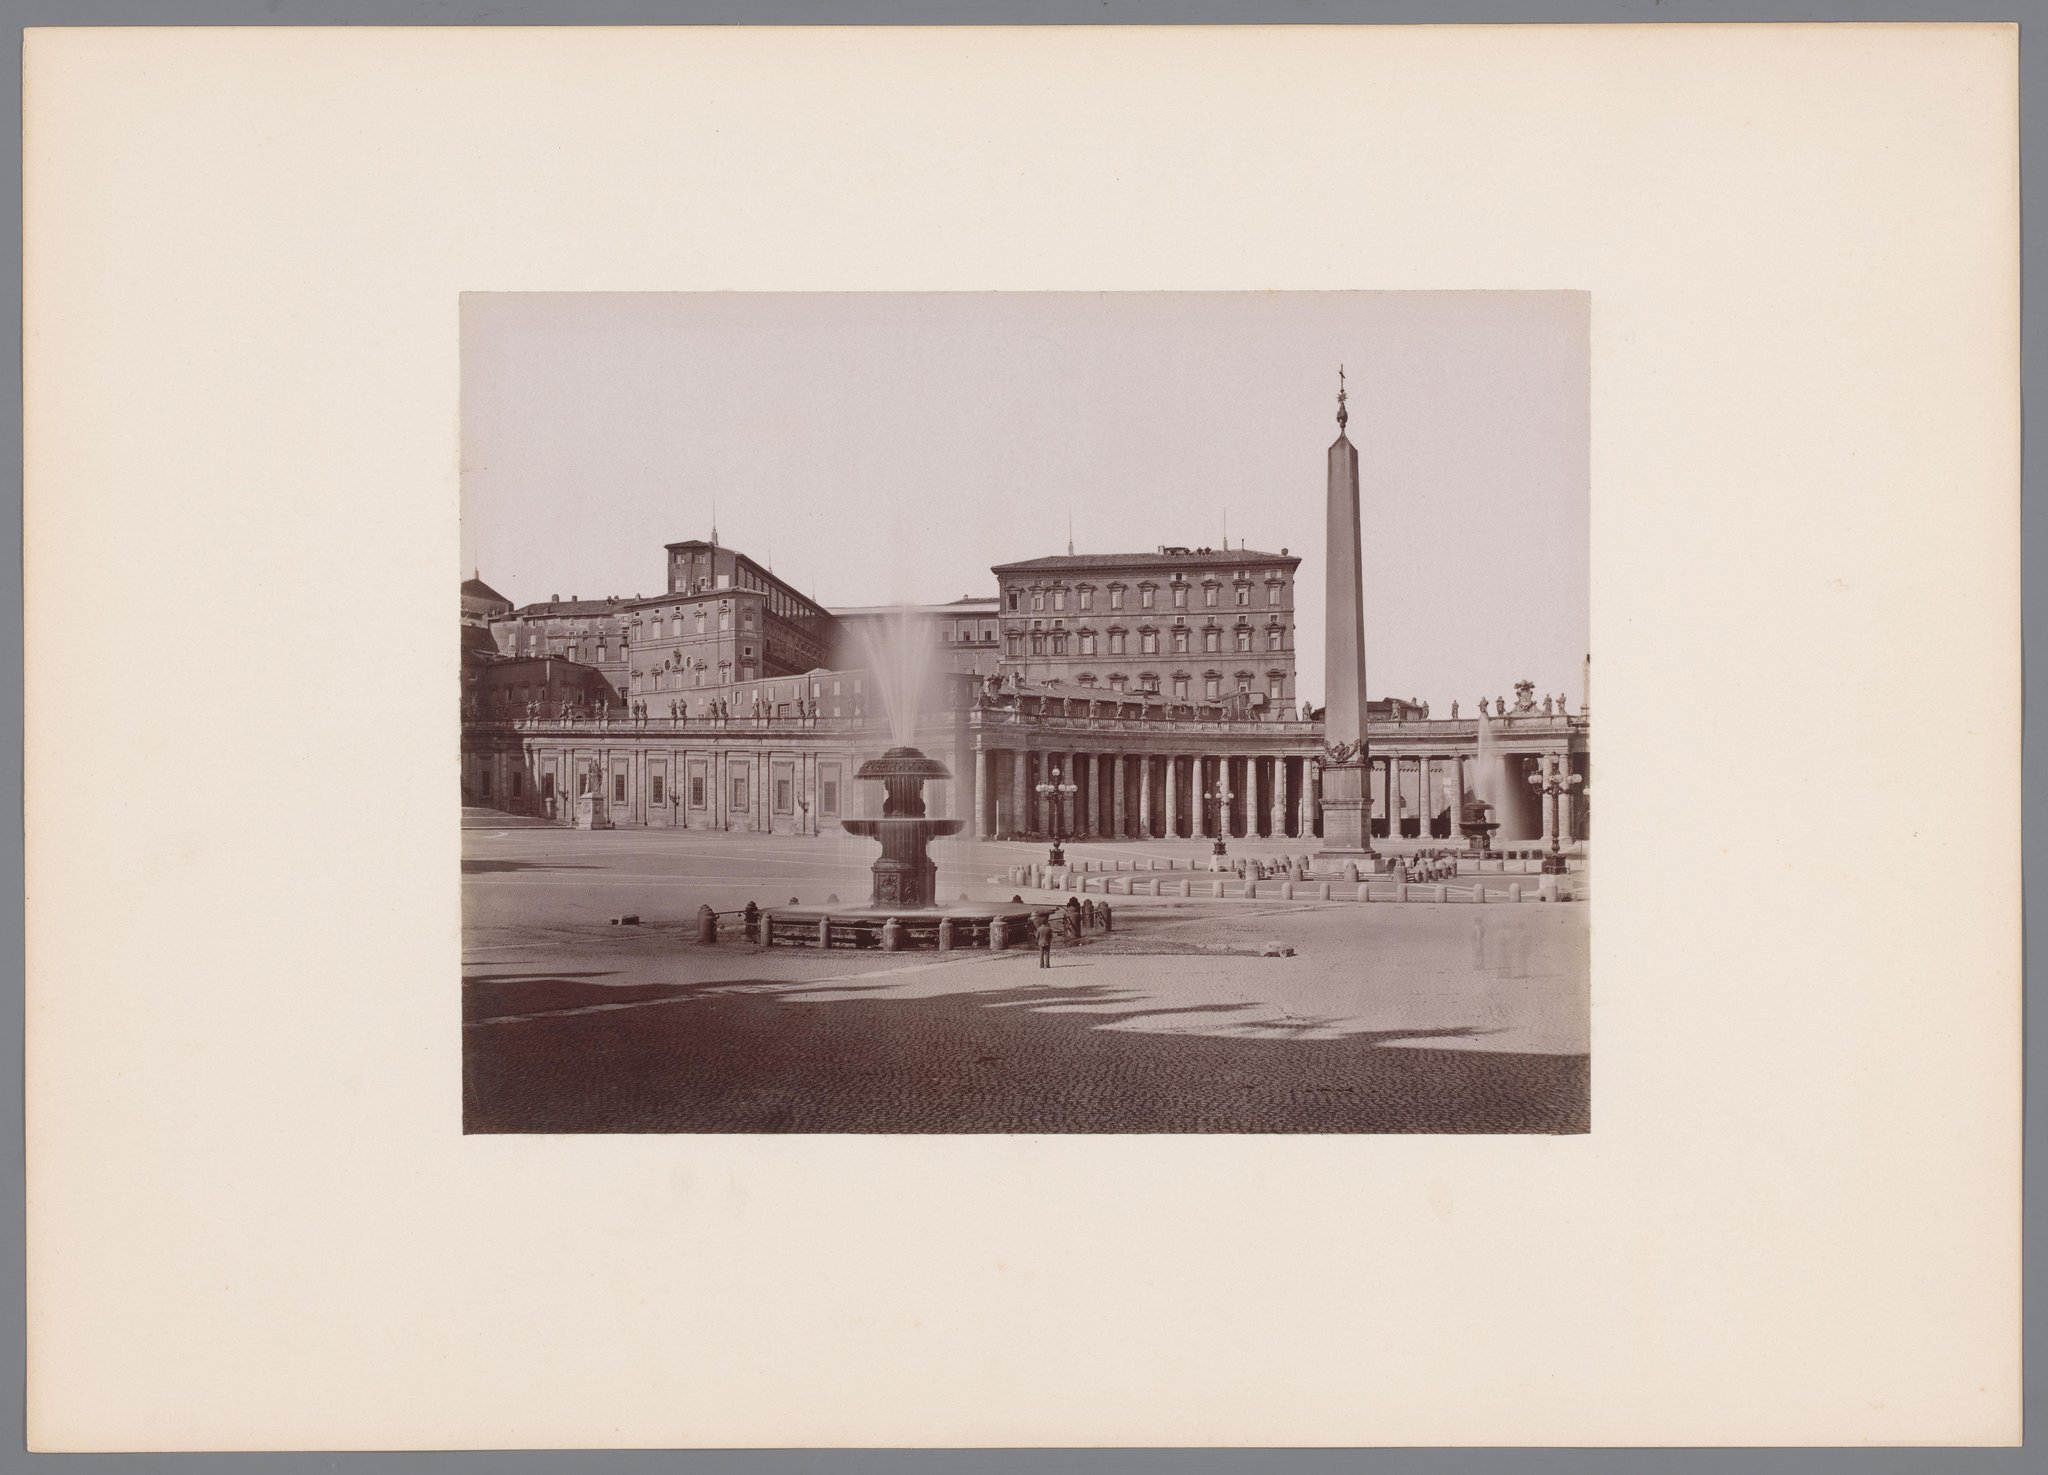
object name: photograph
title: Gezicht op het Sint-Pietersplein en het Apostolisch Paleis te Vaticaanstad, Italië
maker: giacomo brogi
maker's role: fotograaf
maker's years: 1822-1881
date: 1864-1881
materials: cardboard, paper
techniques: albumen print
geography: vatican city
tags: square, place, circus, etc., palace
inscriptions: number: ‘98’, number: ‘3631.’